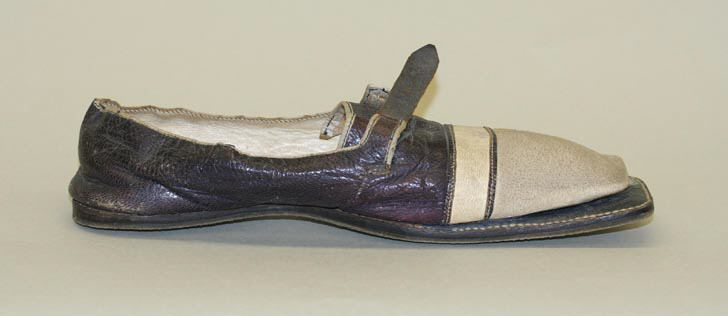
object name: shoe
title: Shoes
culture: italian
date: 1801-1833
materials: leather